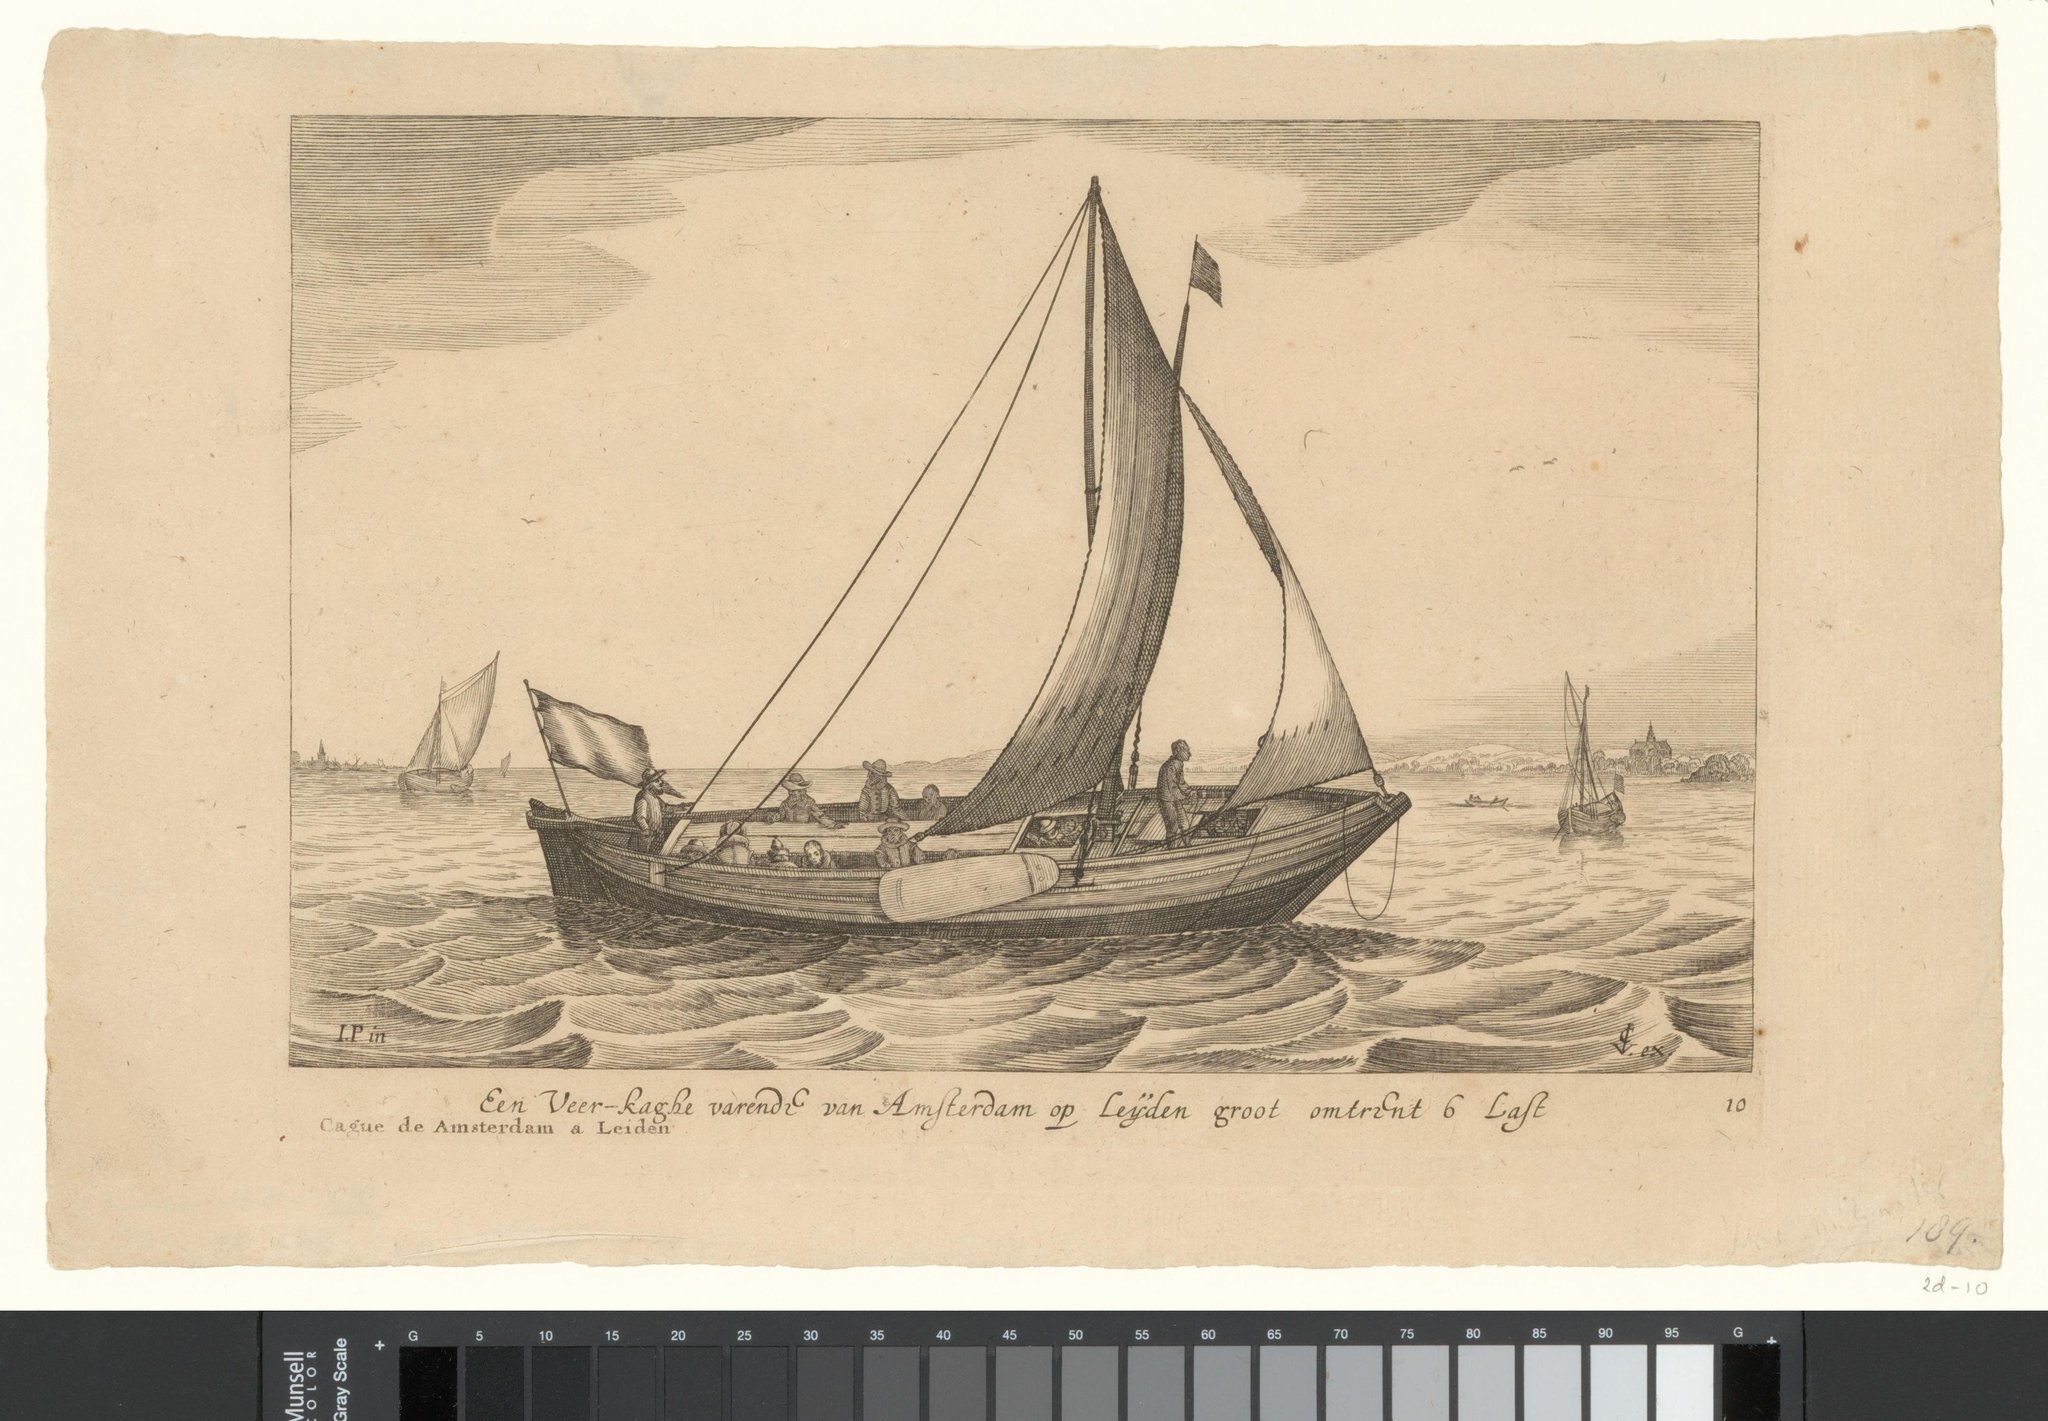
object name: print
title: Schepen gebruikt in de Verenigde Provinciën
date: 1717-1779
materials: paper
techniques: engraving, etching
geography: haarlem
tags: sailing-ship, sailing-boat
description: Een veerkaag varend tussen Amsterdam en Leiden. Rechtsonder genummerd: 10. Onderwerpsrubrieken binnen de Atlas Zeden en Gewoonten: Handel, Nijverheid en Verkeer, Scheepsvaart.